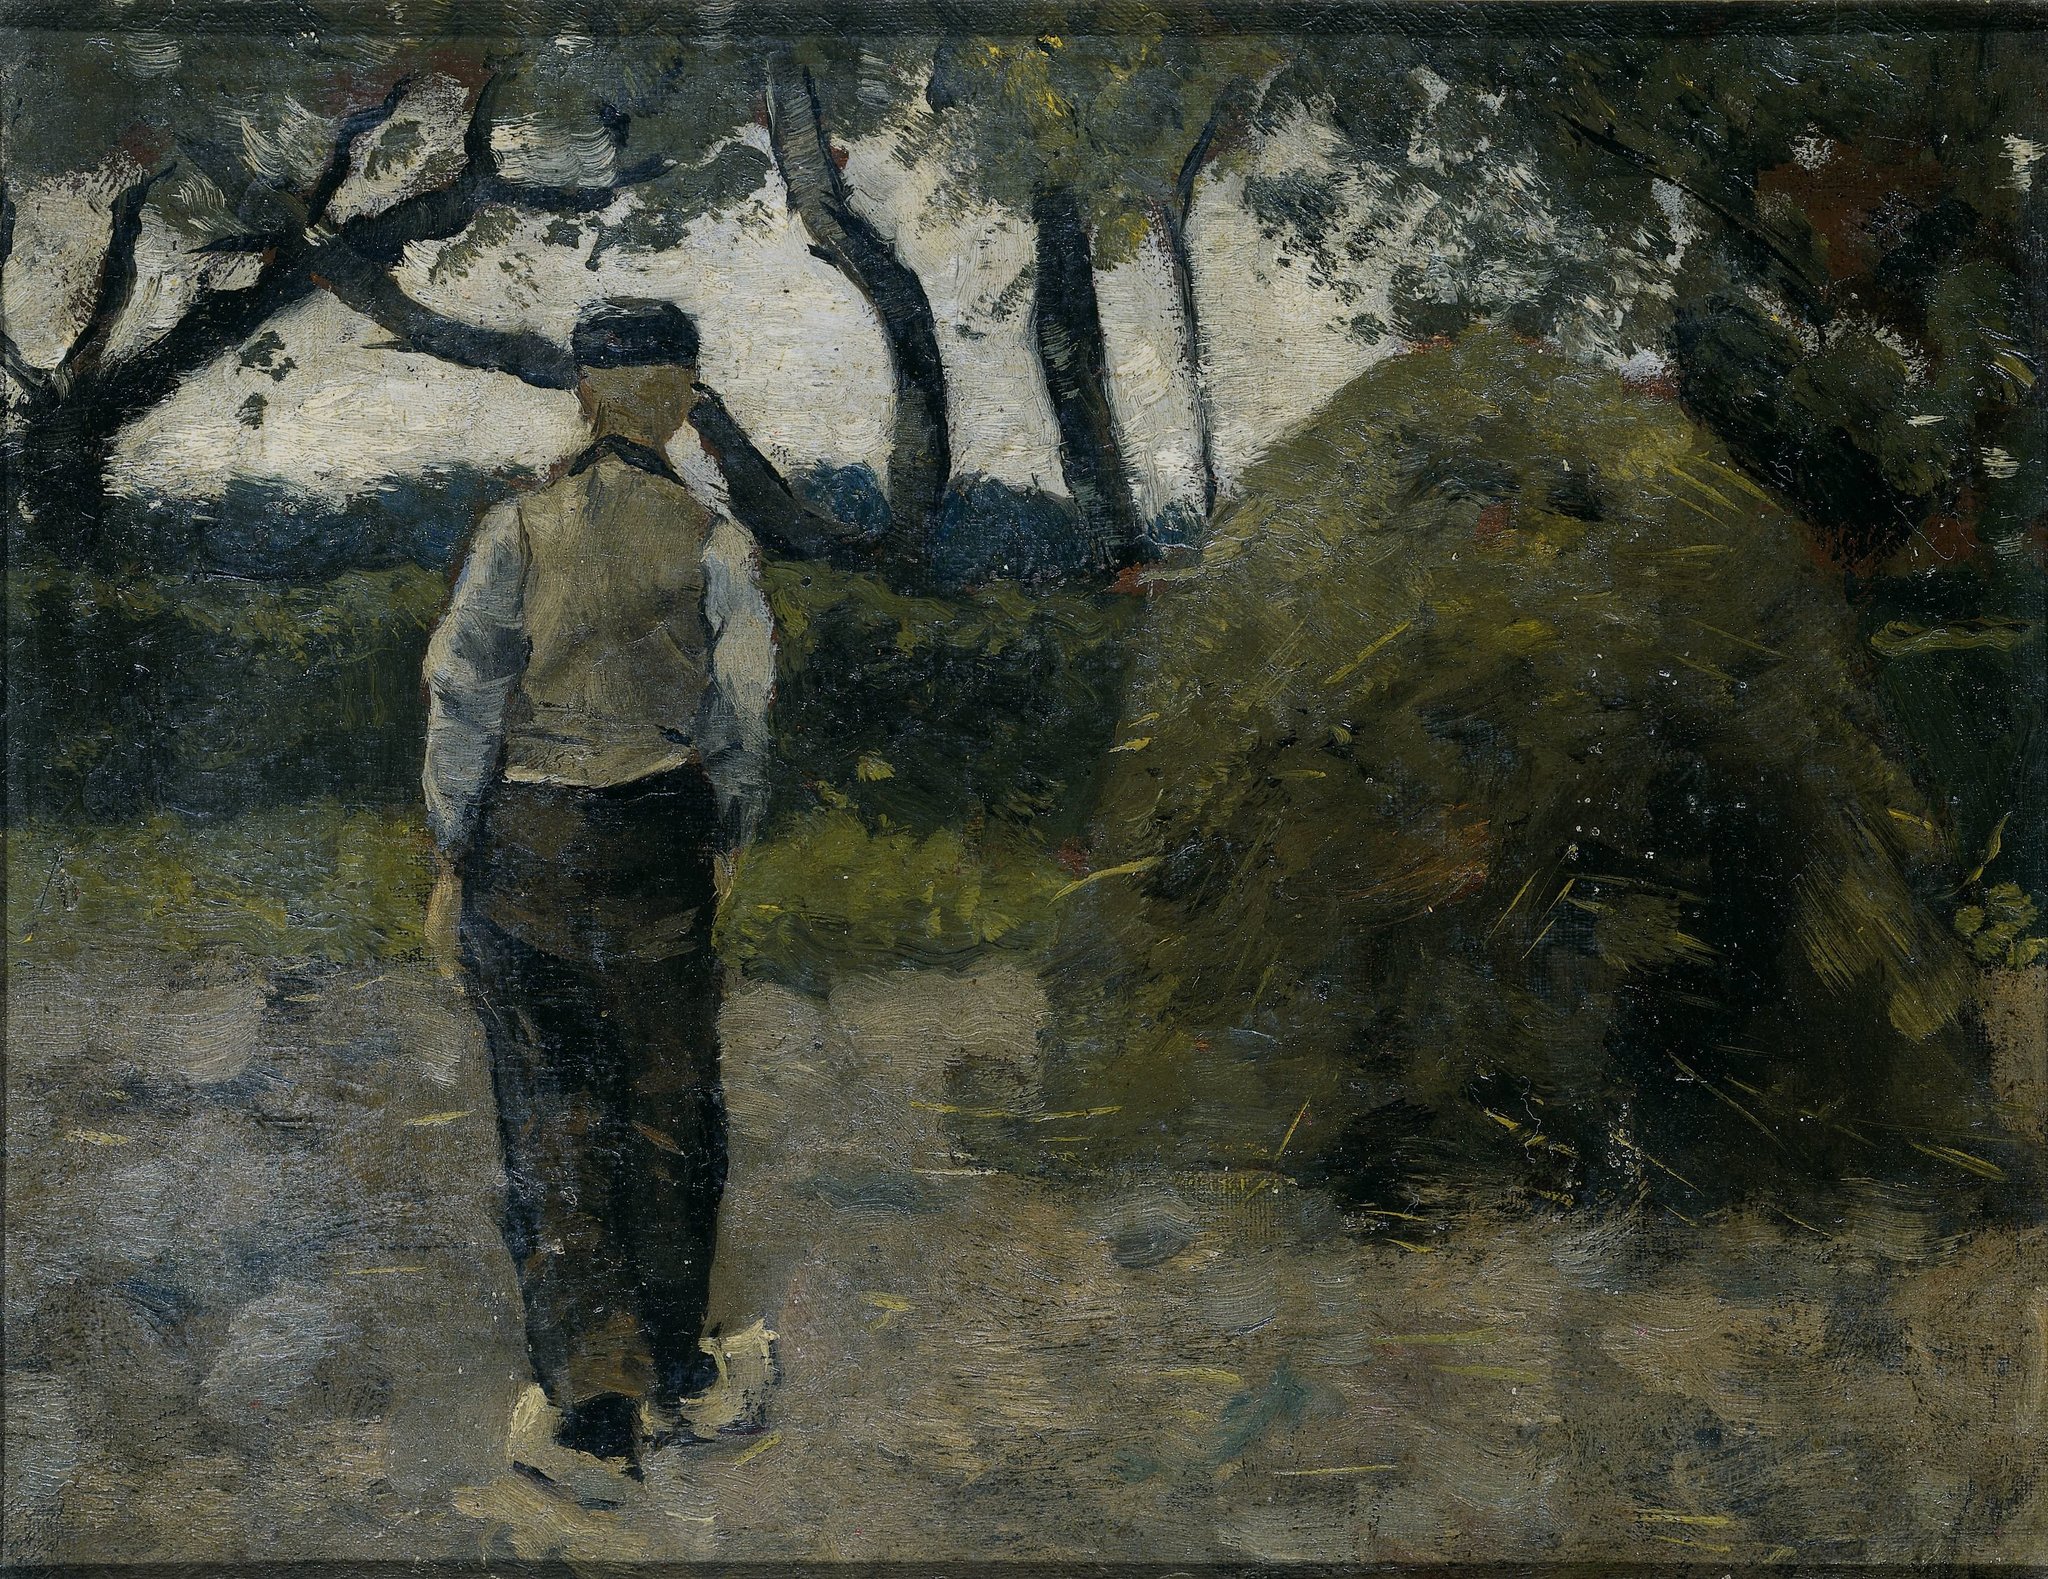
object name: painting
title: A Farmer standing near a Hay-Stack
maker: richard nicolaüs roland holst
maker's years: 1868-1938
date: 1889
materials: canvas, cardboard, oil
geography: netherlands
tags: farmers, hay-stack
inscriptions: signature and date: ‘Hattum 1889 Rn Roland Holst’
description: Een boer, op de rug gezien, staande bij een hooiberg. Waarschijnlijk geschilderd in de omgeving van Hattem.